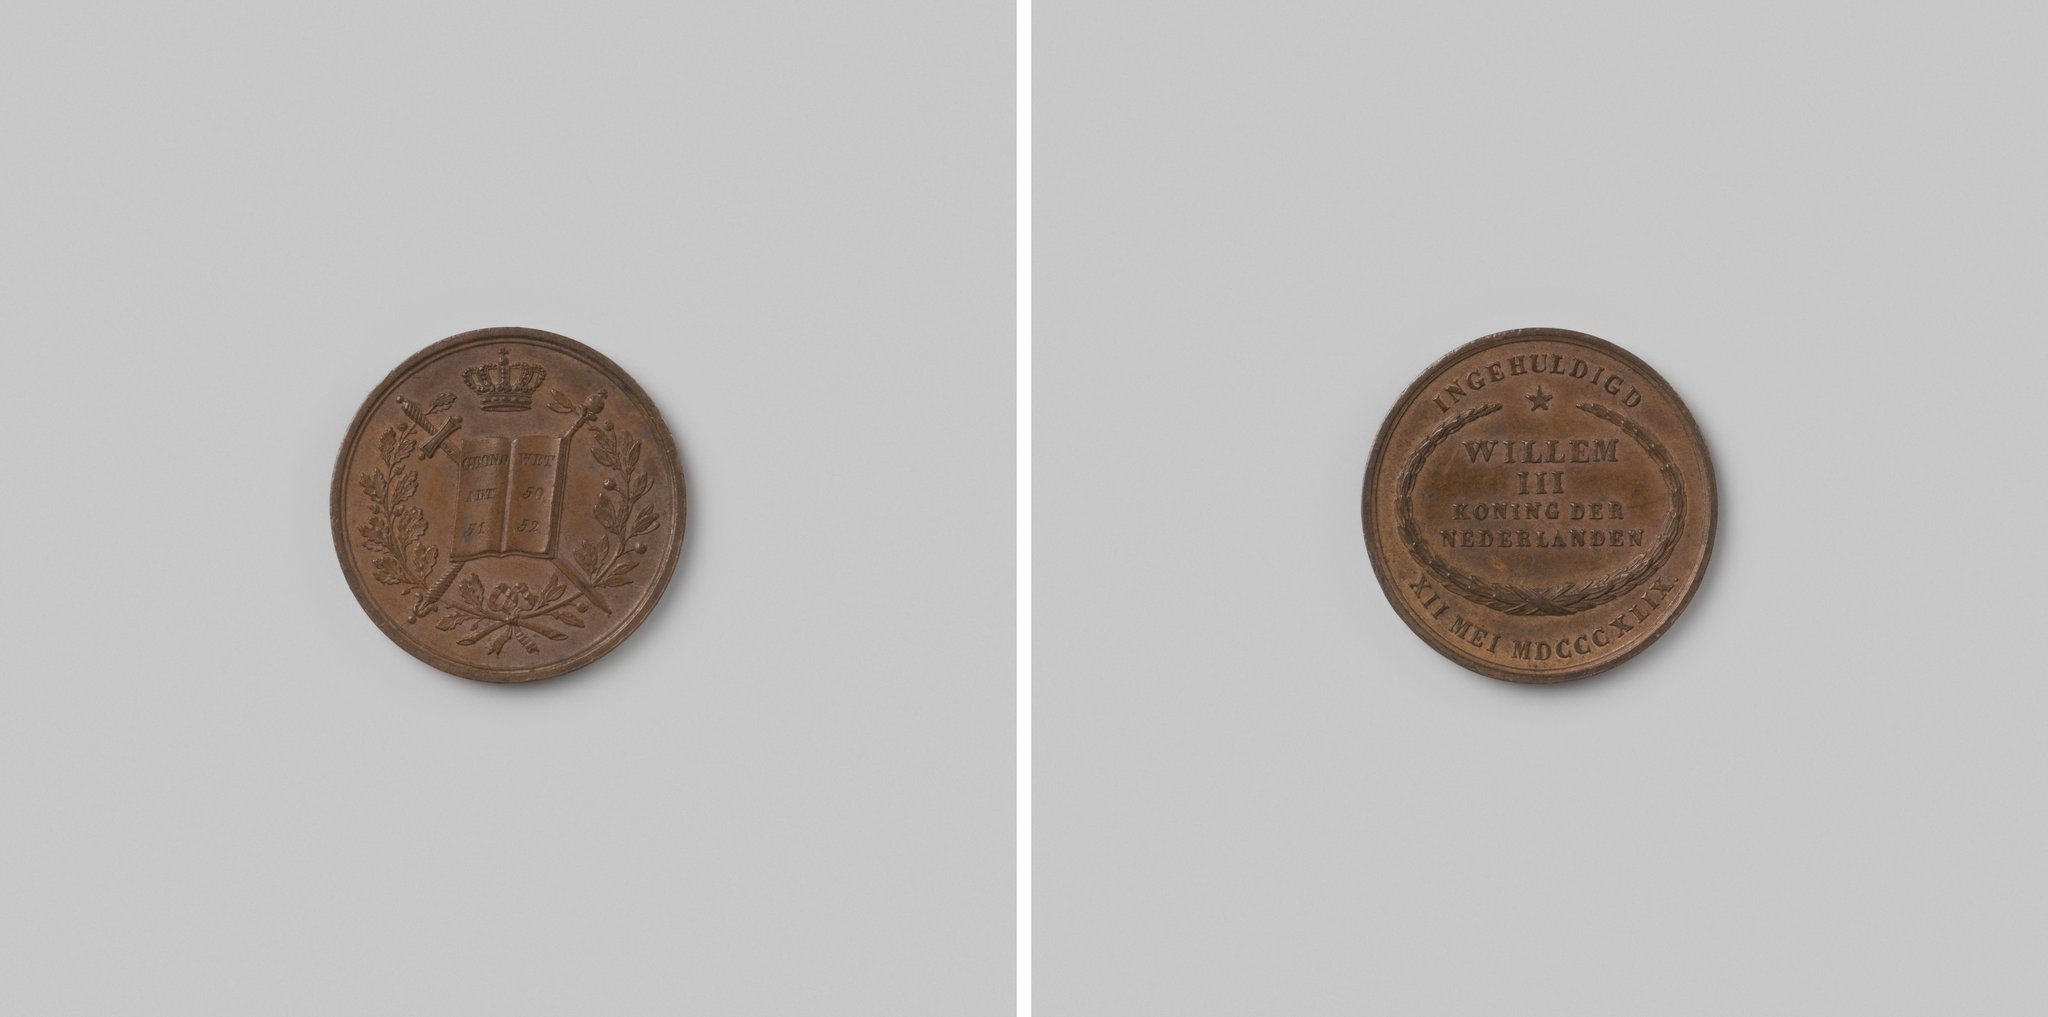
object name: strooipenning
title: Inhuldiging van Willem III tot koning der Nederlanden te Amsterdam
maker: johannis petrus schouberg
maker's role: die cutter, draughtsman, print maker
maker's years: 1798-1864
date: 1849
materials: bronze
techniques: striking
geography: netherlands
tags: brussels, willem iii (koning der nederlanden), amsterdam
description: Bronzen penning. Voorzijde: geopend boek op gekruiste scepter en zwaard binnen tot krans samengebonden oranje- en eiketak onder kroon. Keerzijde: opschrift binnen lauwerkrans onder ster binnen omschrift